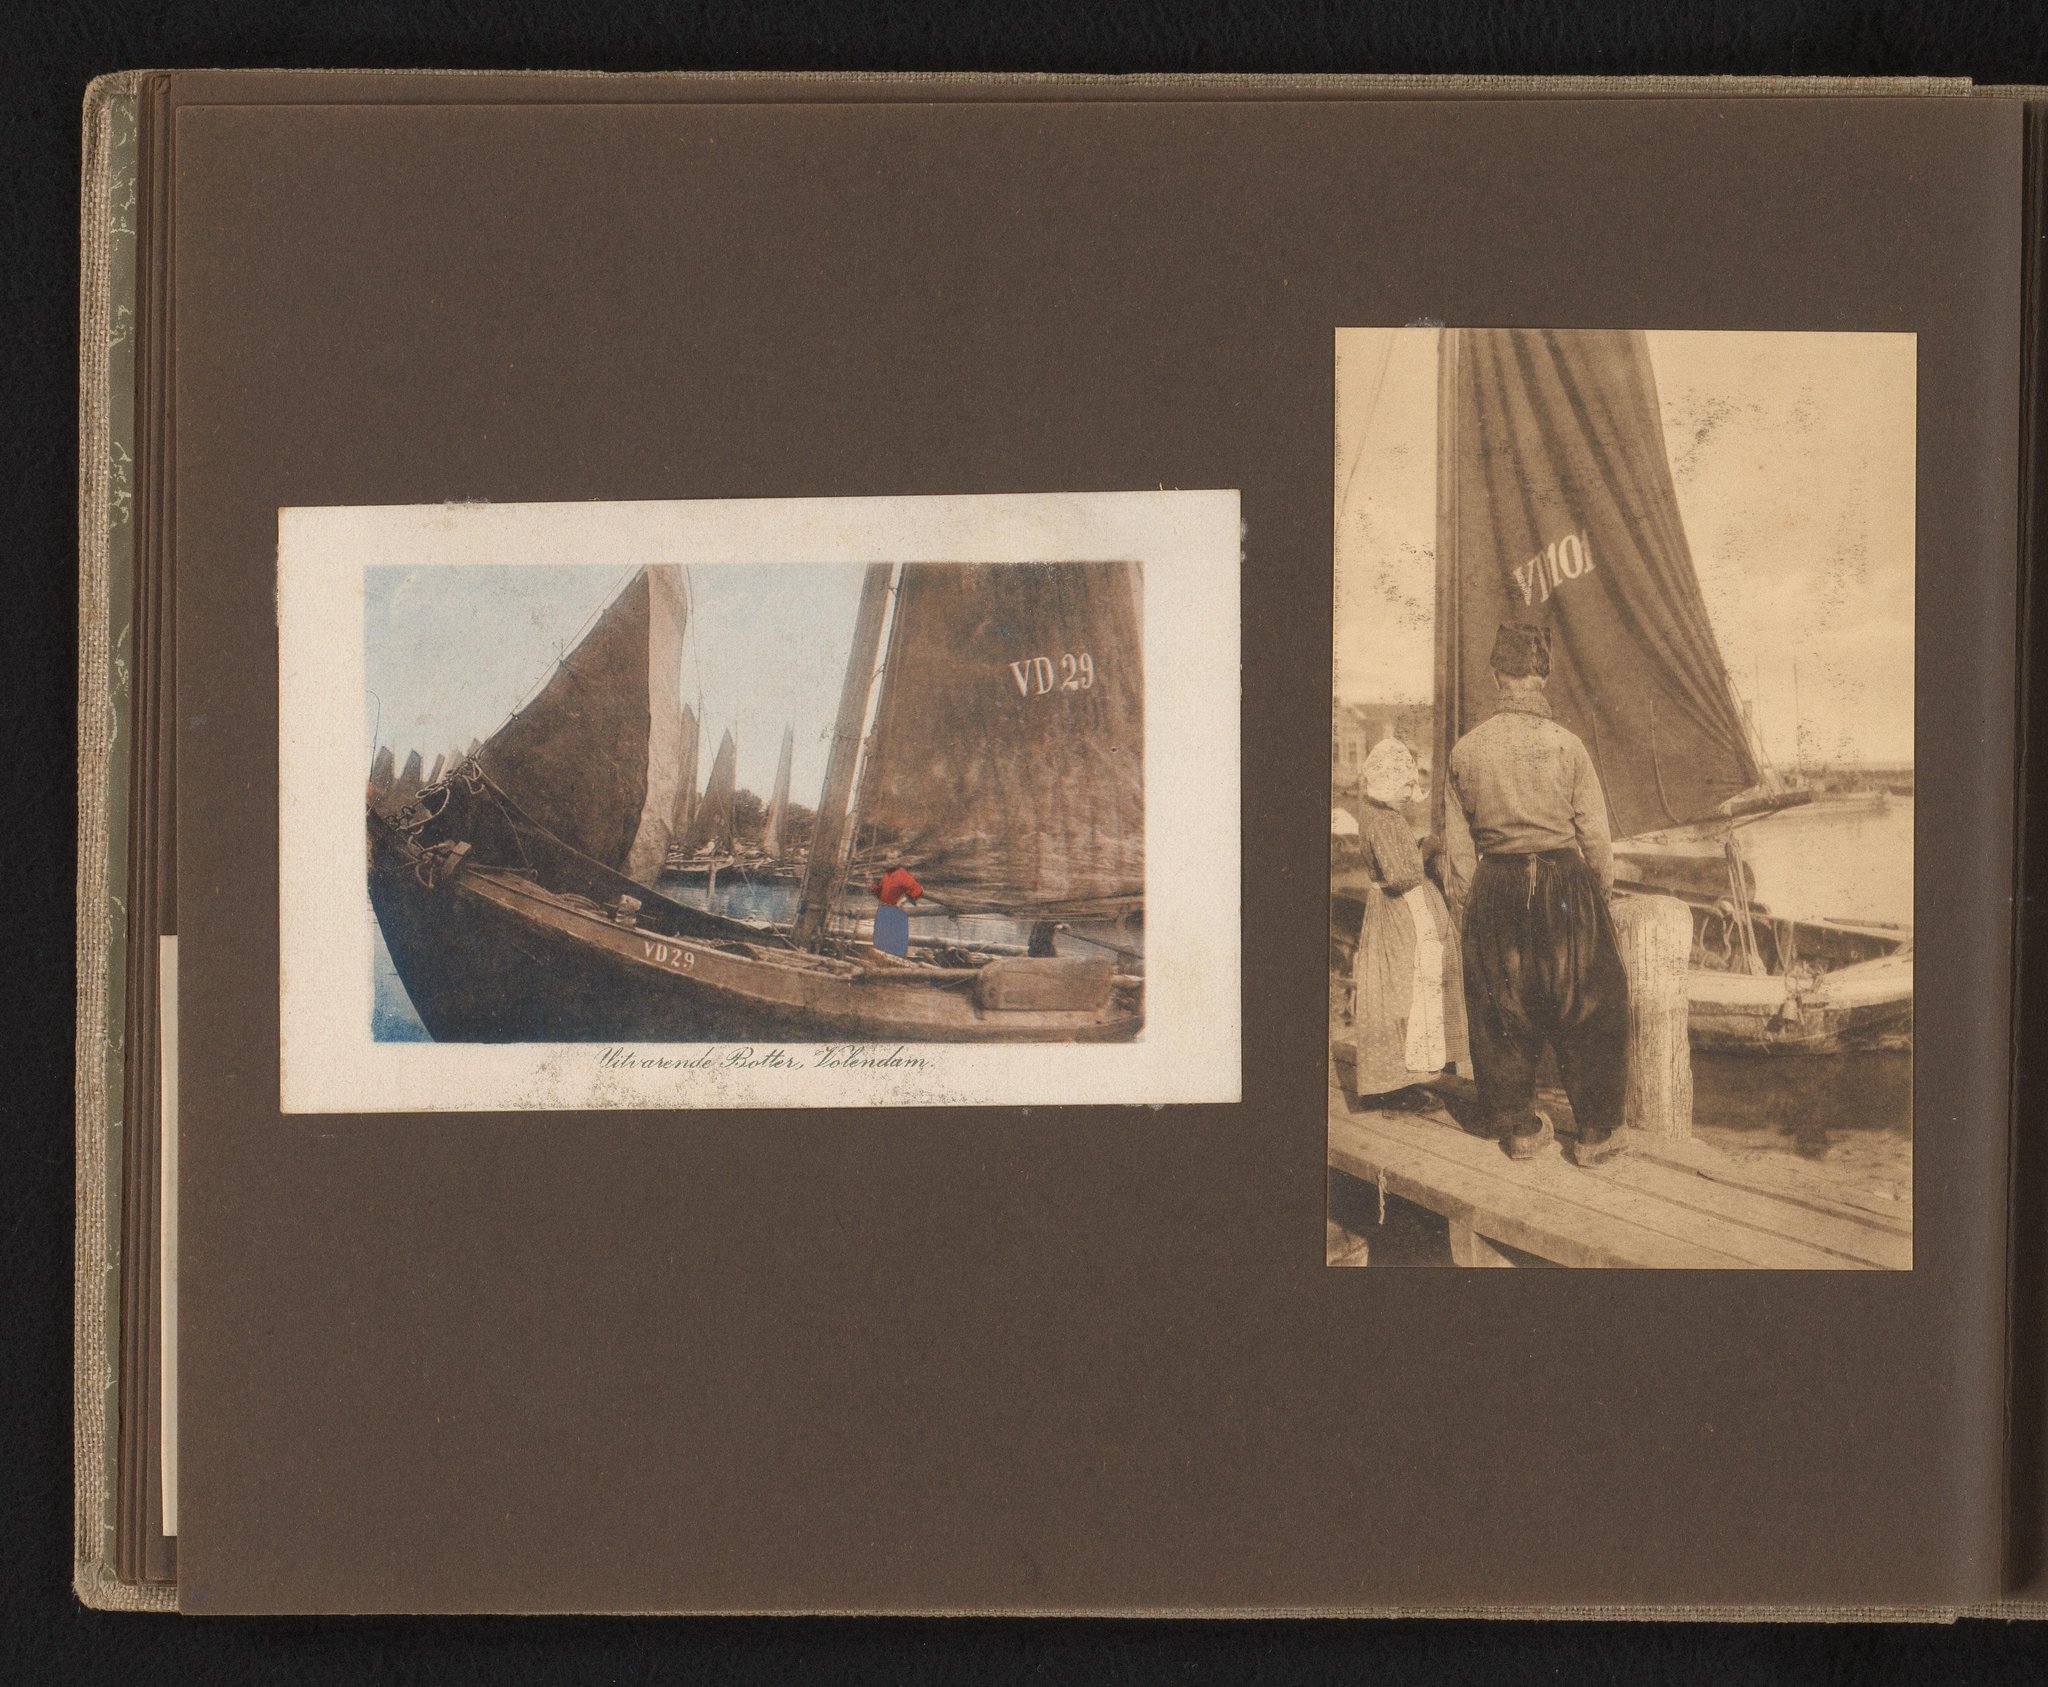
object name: ansichtkaart, prentbriefkaart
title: Haven met een botter in Volendam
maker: Anonymous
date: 1875-1930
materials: cardboard, paper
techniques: photograph, hand coloring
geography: volendam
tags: harbour, sailing-ship, sailing-boat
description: Deze prentbriefkaarten maken deel uit van een album.